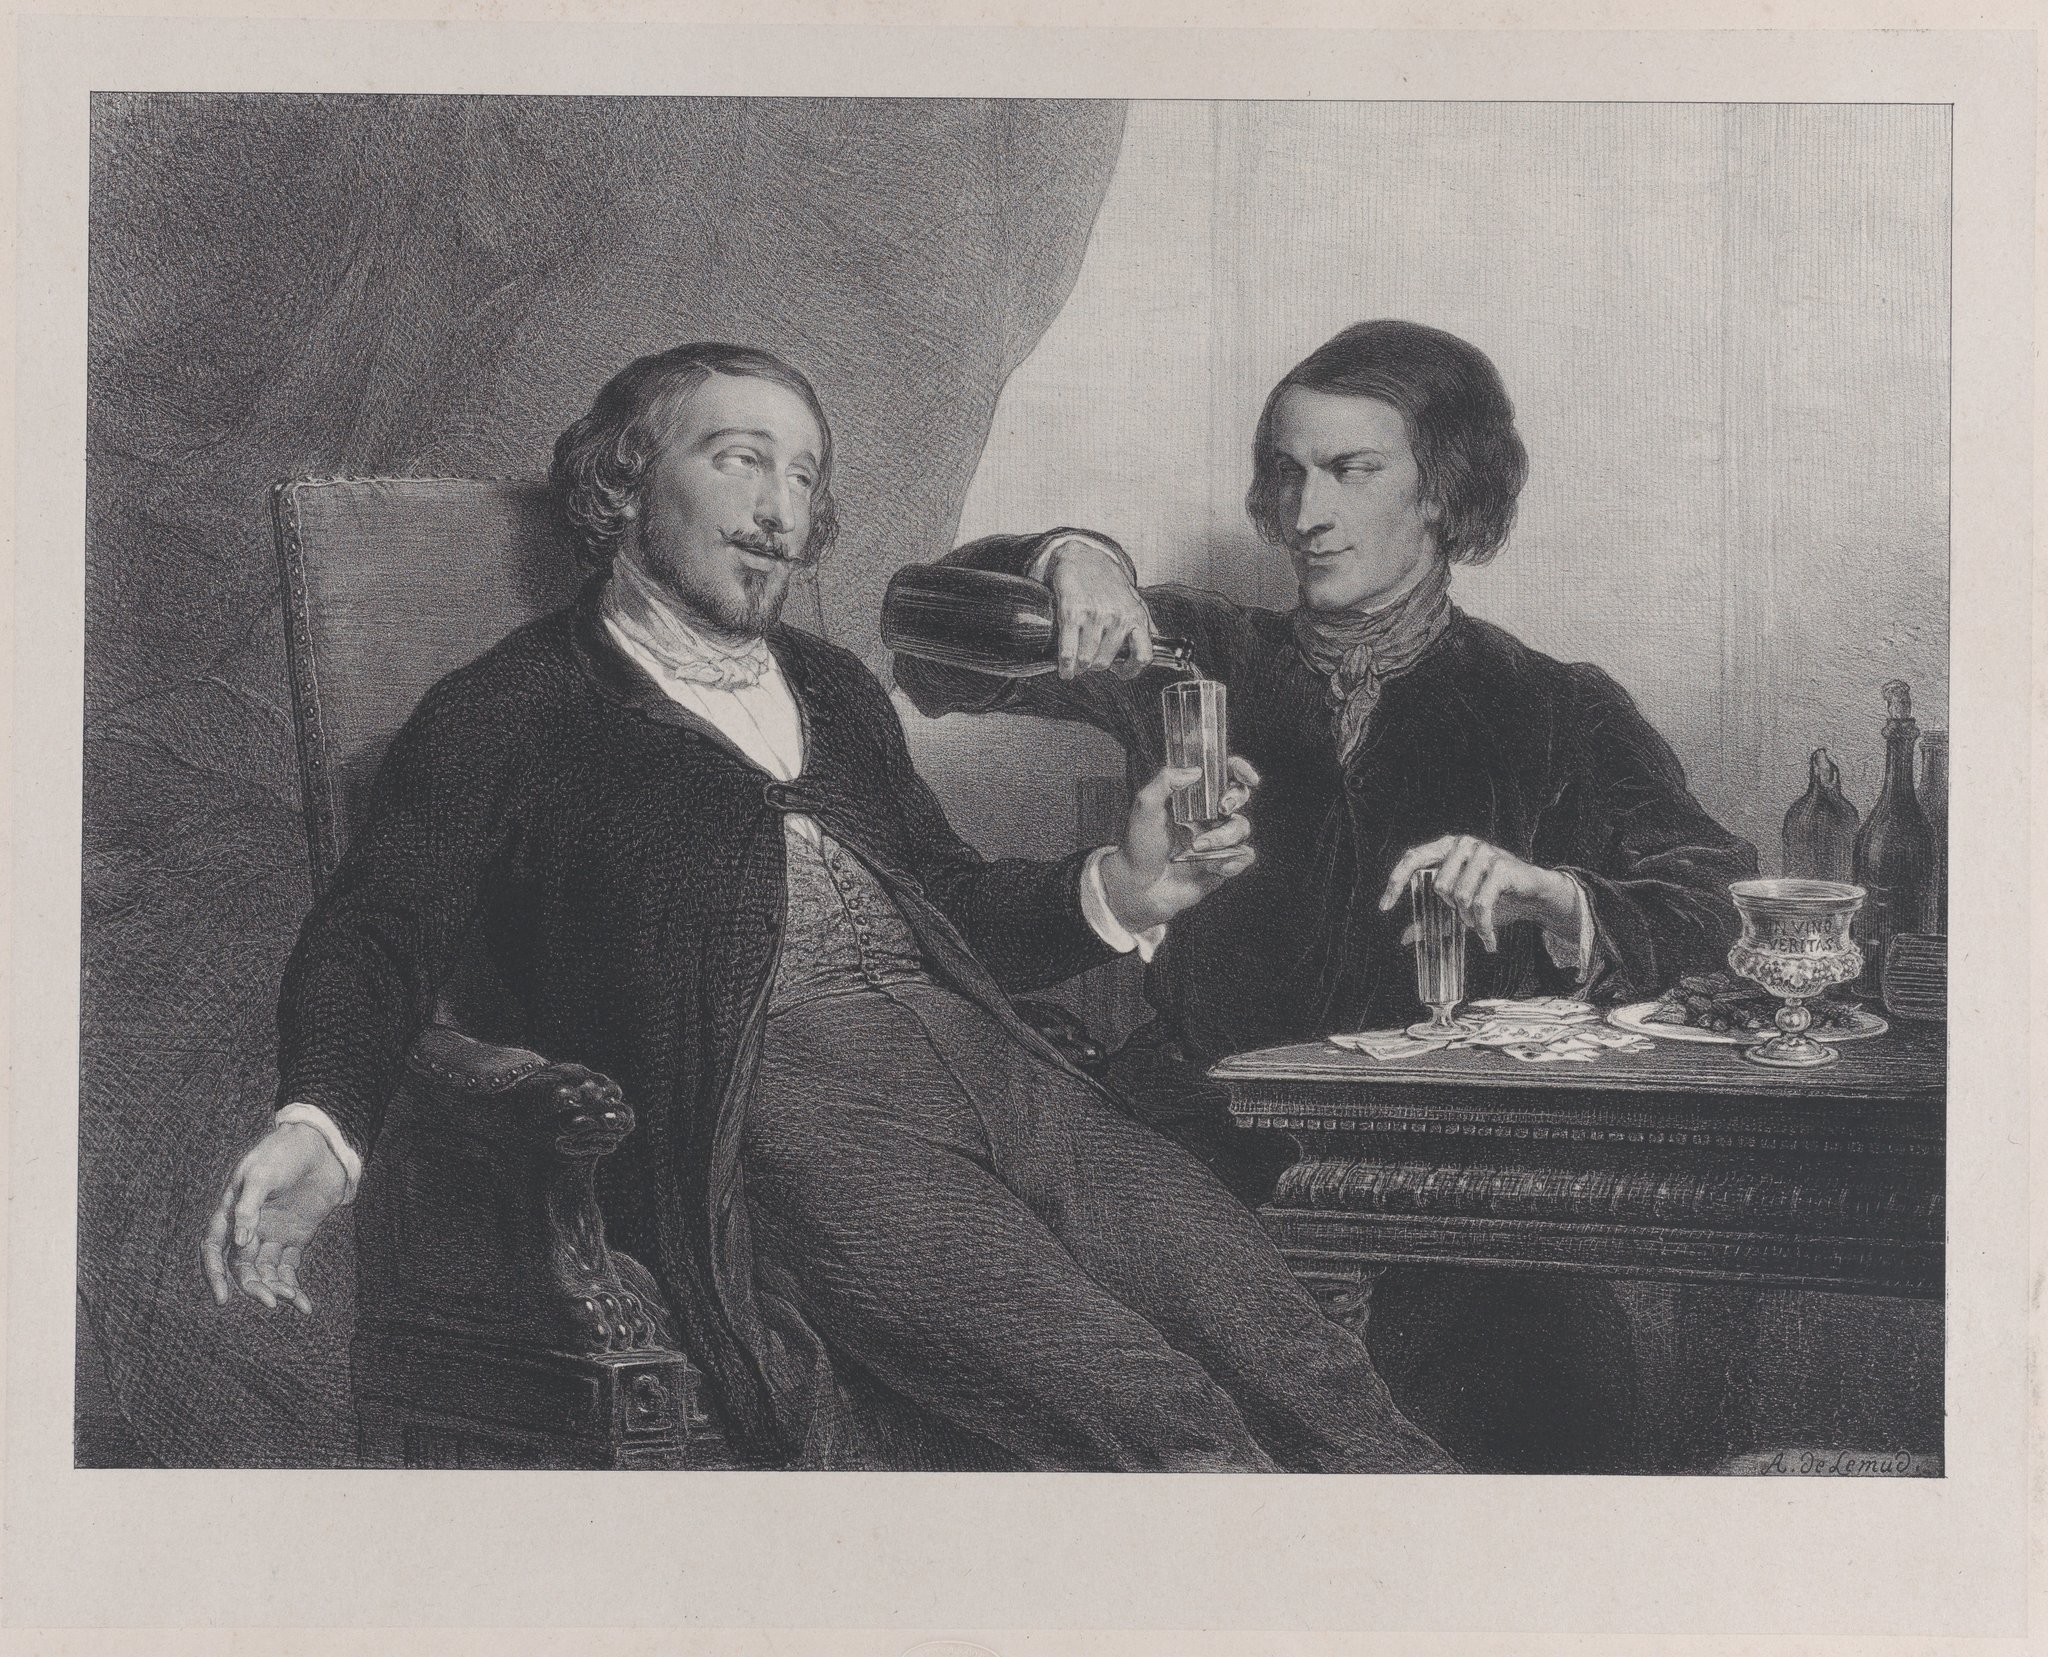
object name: print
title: Le Vin (Wine)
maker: françois-joseph-aimé de lemud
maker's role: artist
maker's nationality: french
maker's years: 1816-1887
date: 1840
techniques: lithograph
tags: wine,men,drinking